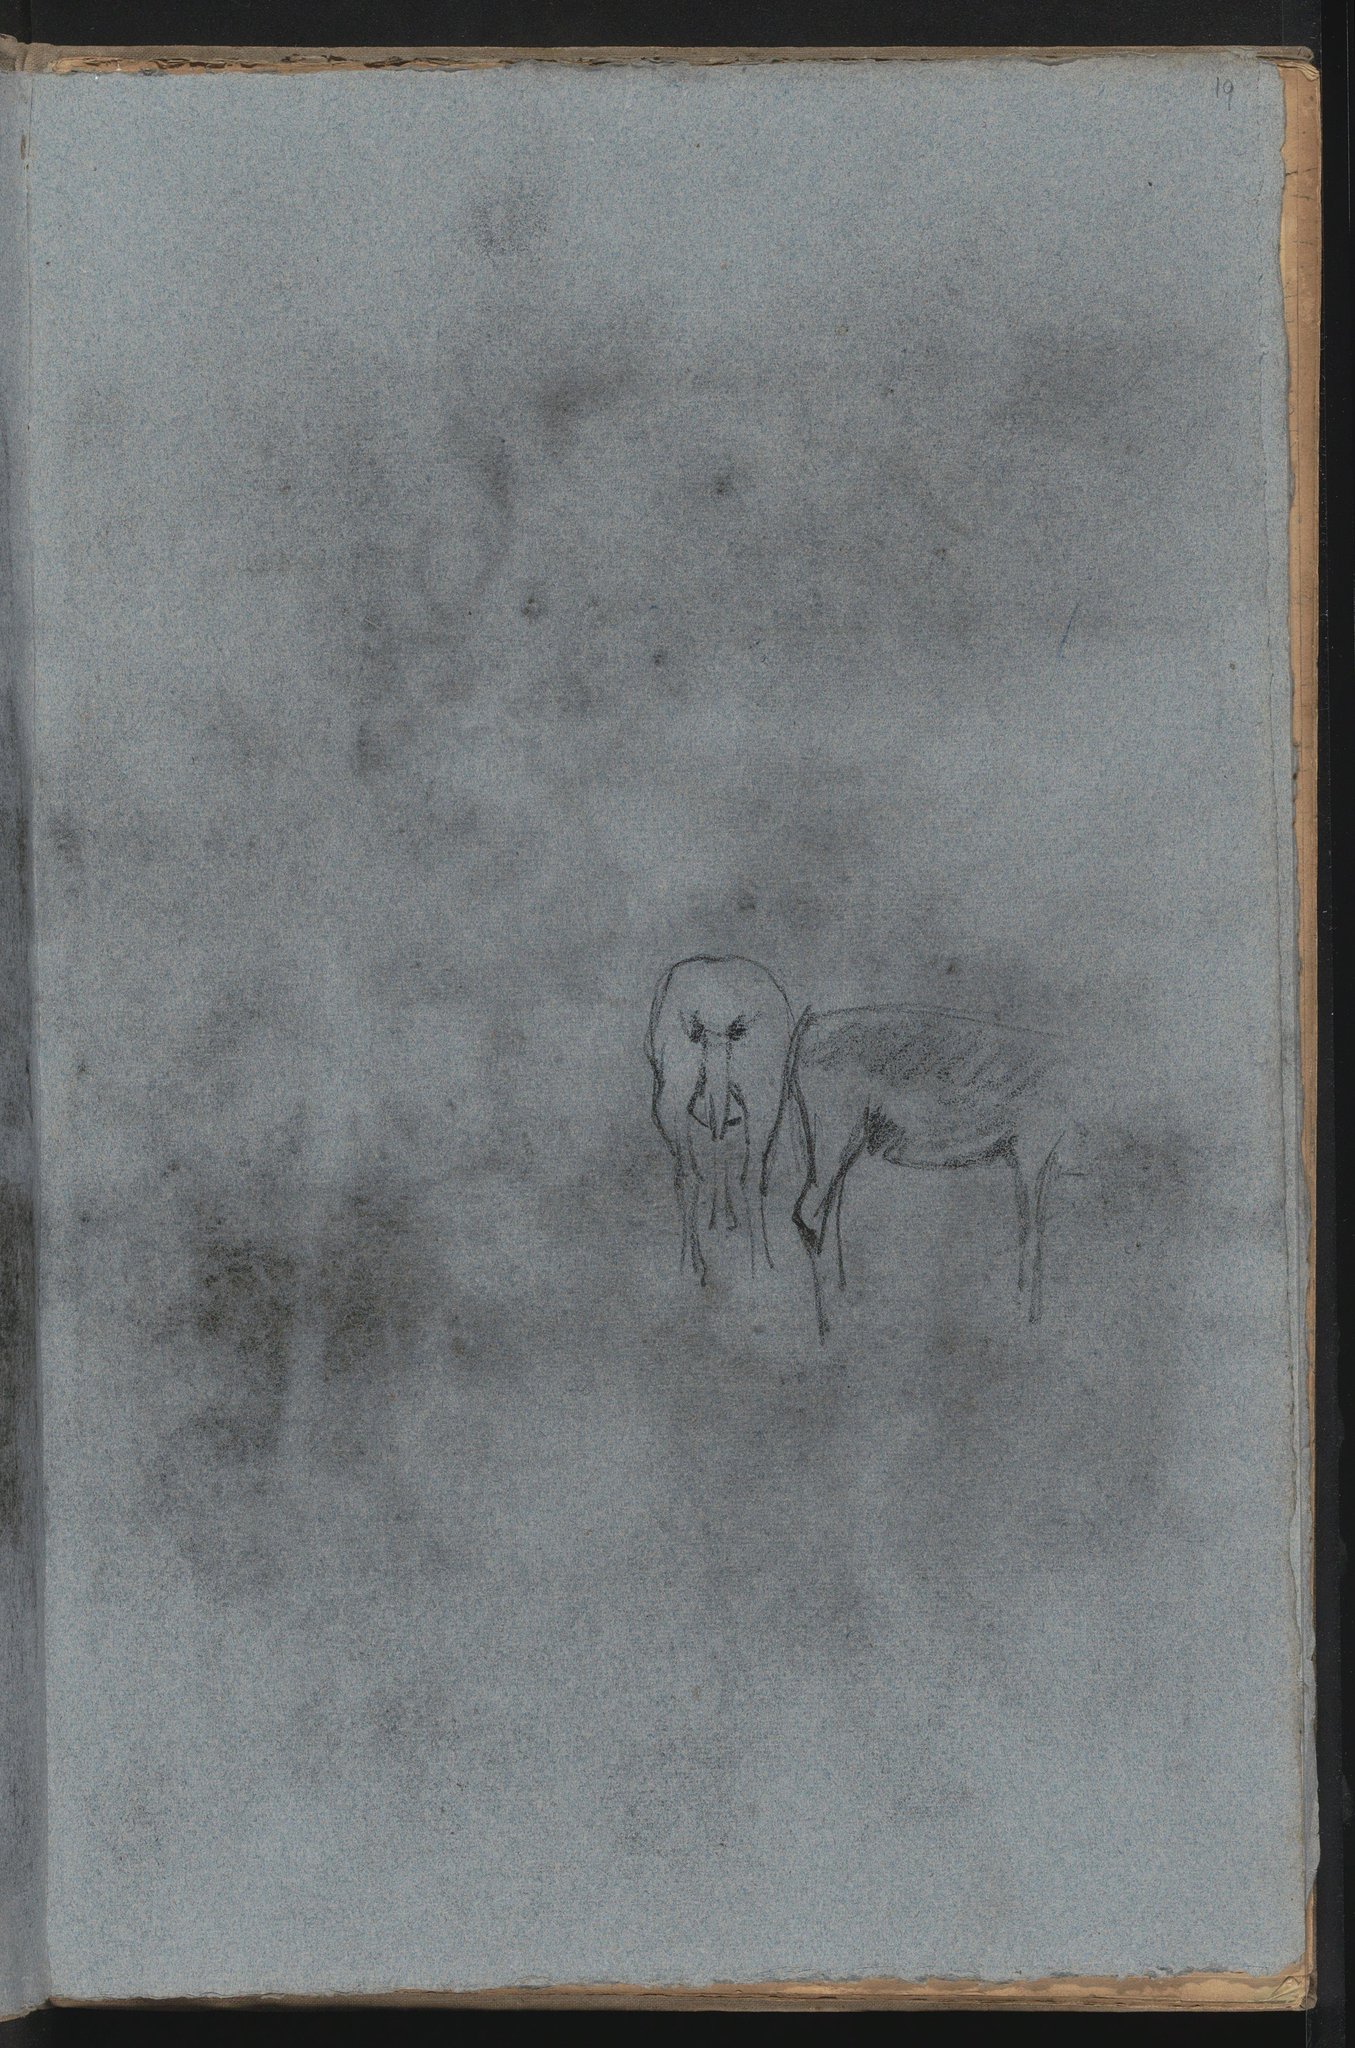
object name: sketchbook leaf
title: Twee schapen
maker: willem witsen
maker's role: draughtsman, painter, print maker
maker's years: 1860-1923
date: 1884-1887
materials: chalk, paper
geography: ewijkshoeve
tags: sheep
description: Pagina 19 uit een schetsboek met 45 bladen vervaardigd rond de Ewijkshoeve.